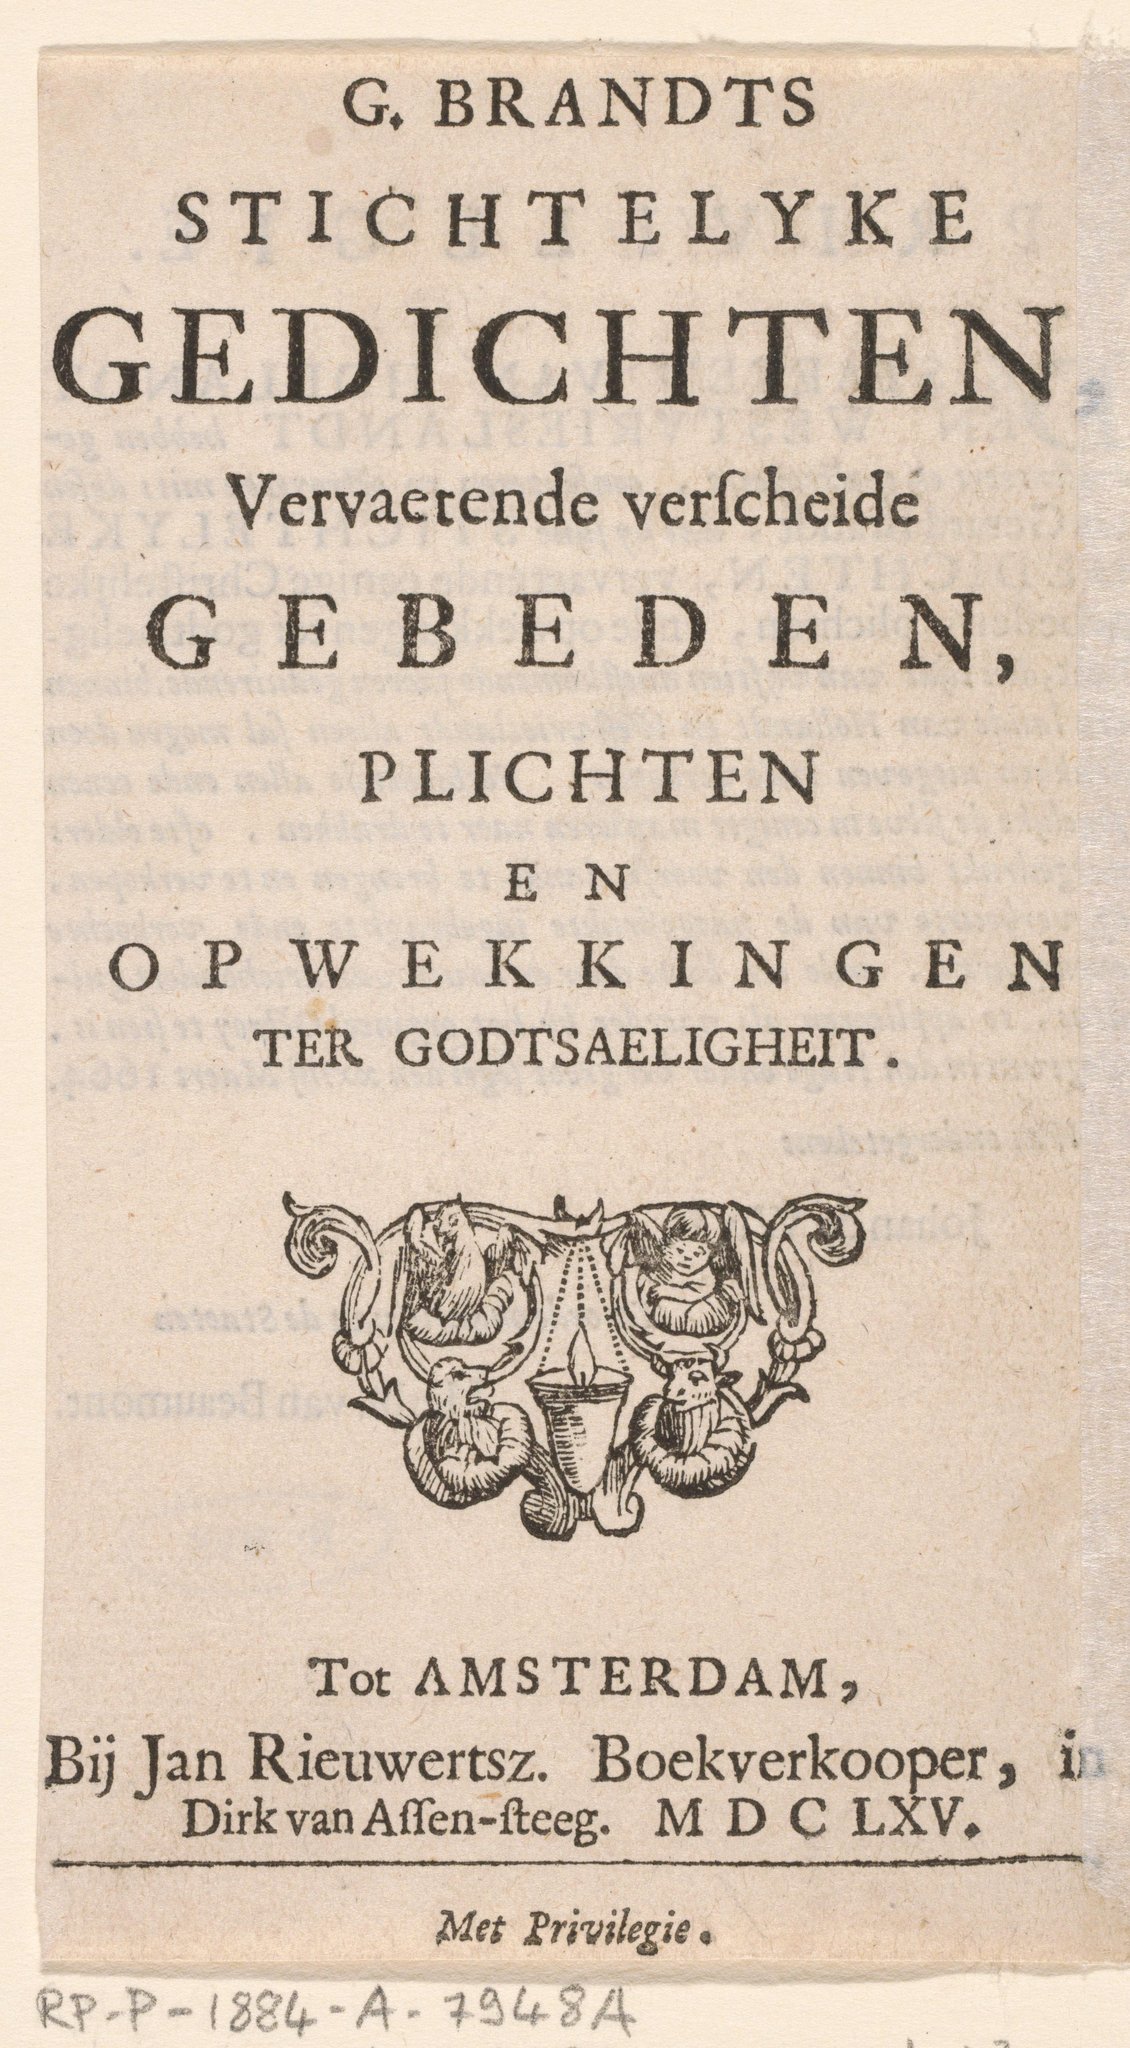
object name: print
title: Titelpagina voor: G. Brandt, Stichtelyke gedichten. Amsterdam, 1665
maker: jan rieuwertsz. (i)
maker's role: printer, publisher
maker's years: 1616-1687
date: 1665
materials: paper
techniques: letterpress printing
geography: amsterdam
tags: title-page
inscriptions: collector's mark: Lugt 2228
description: Titelpagina voor: G. Brandt, Stichtelijke gedichten. Amsterdam, J. Rieuwertsz. 1665 (colofon: gedrukt bij E. van der Hoof, Enchhuysen)